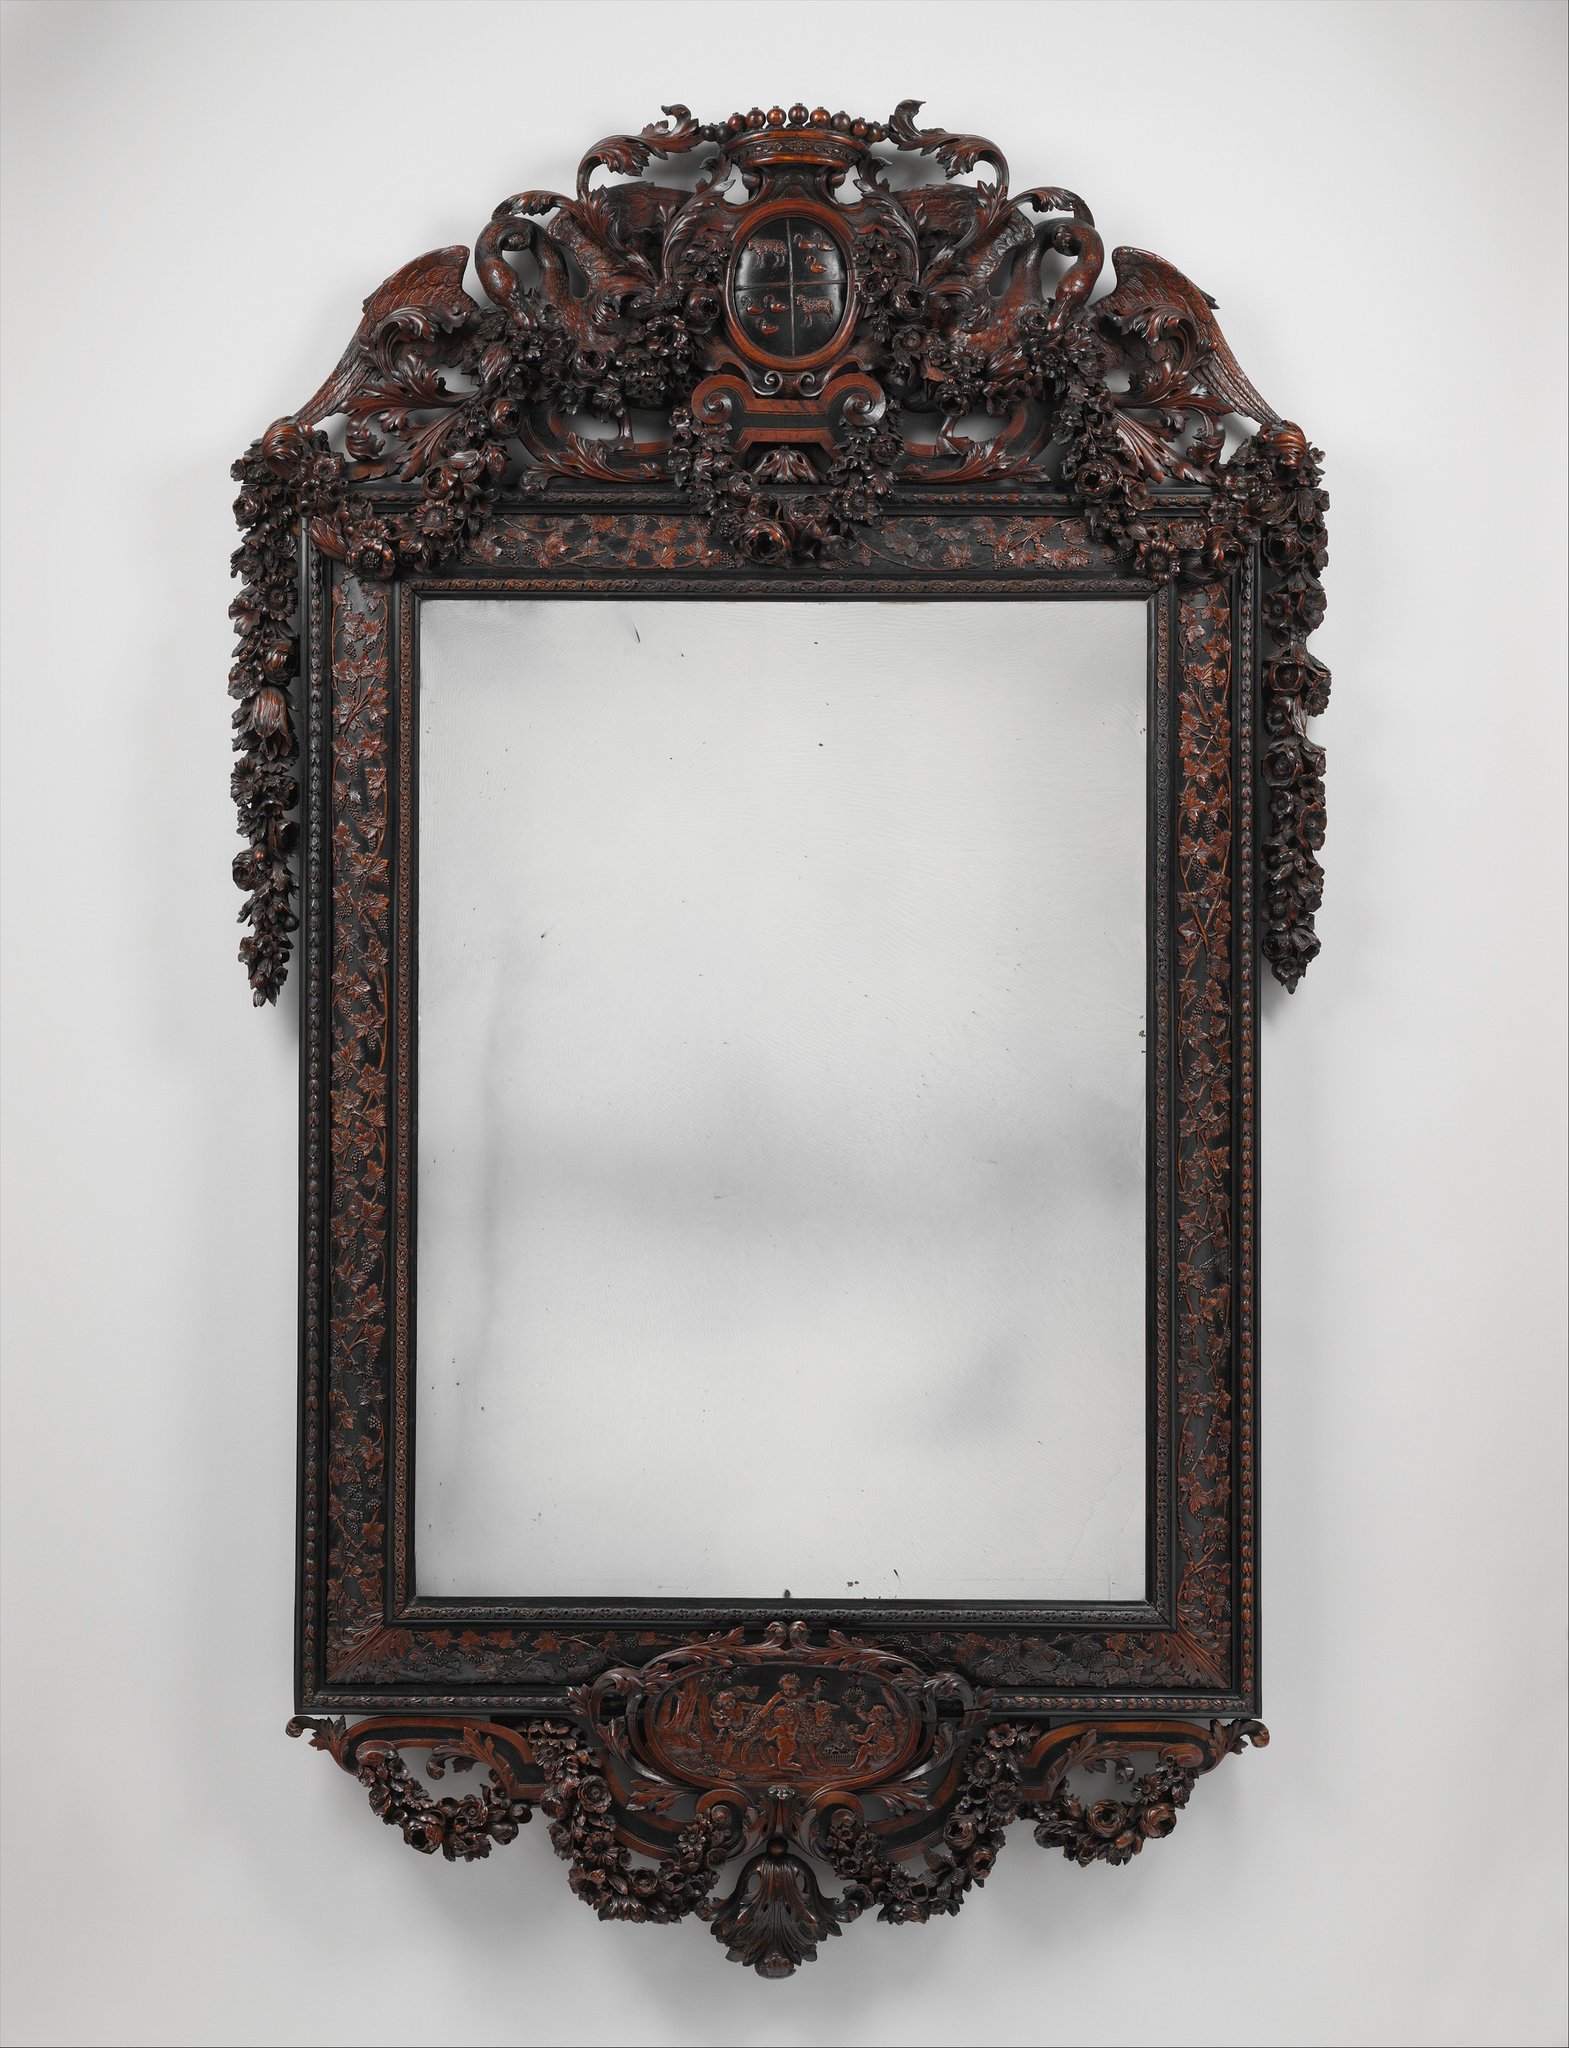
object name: mirror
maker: johannes hannart (or jan hanat)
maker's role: artist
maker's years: 1609-1709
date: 1685-1700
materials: wood, glass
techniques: veneering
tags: putti,swans,flowers,coat of arms